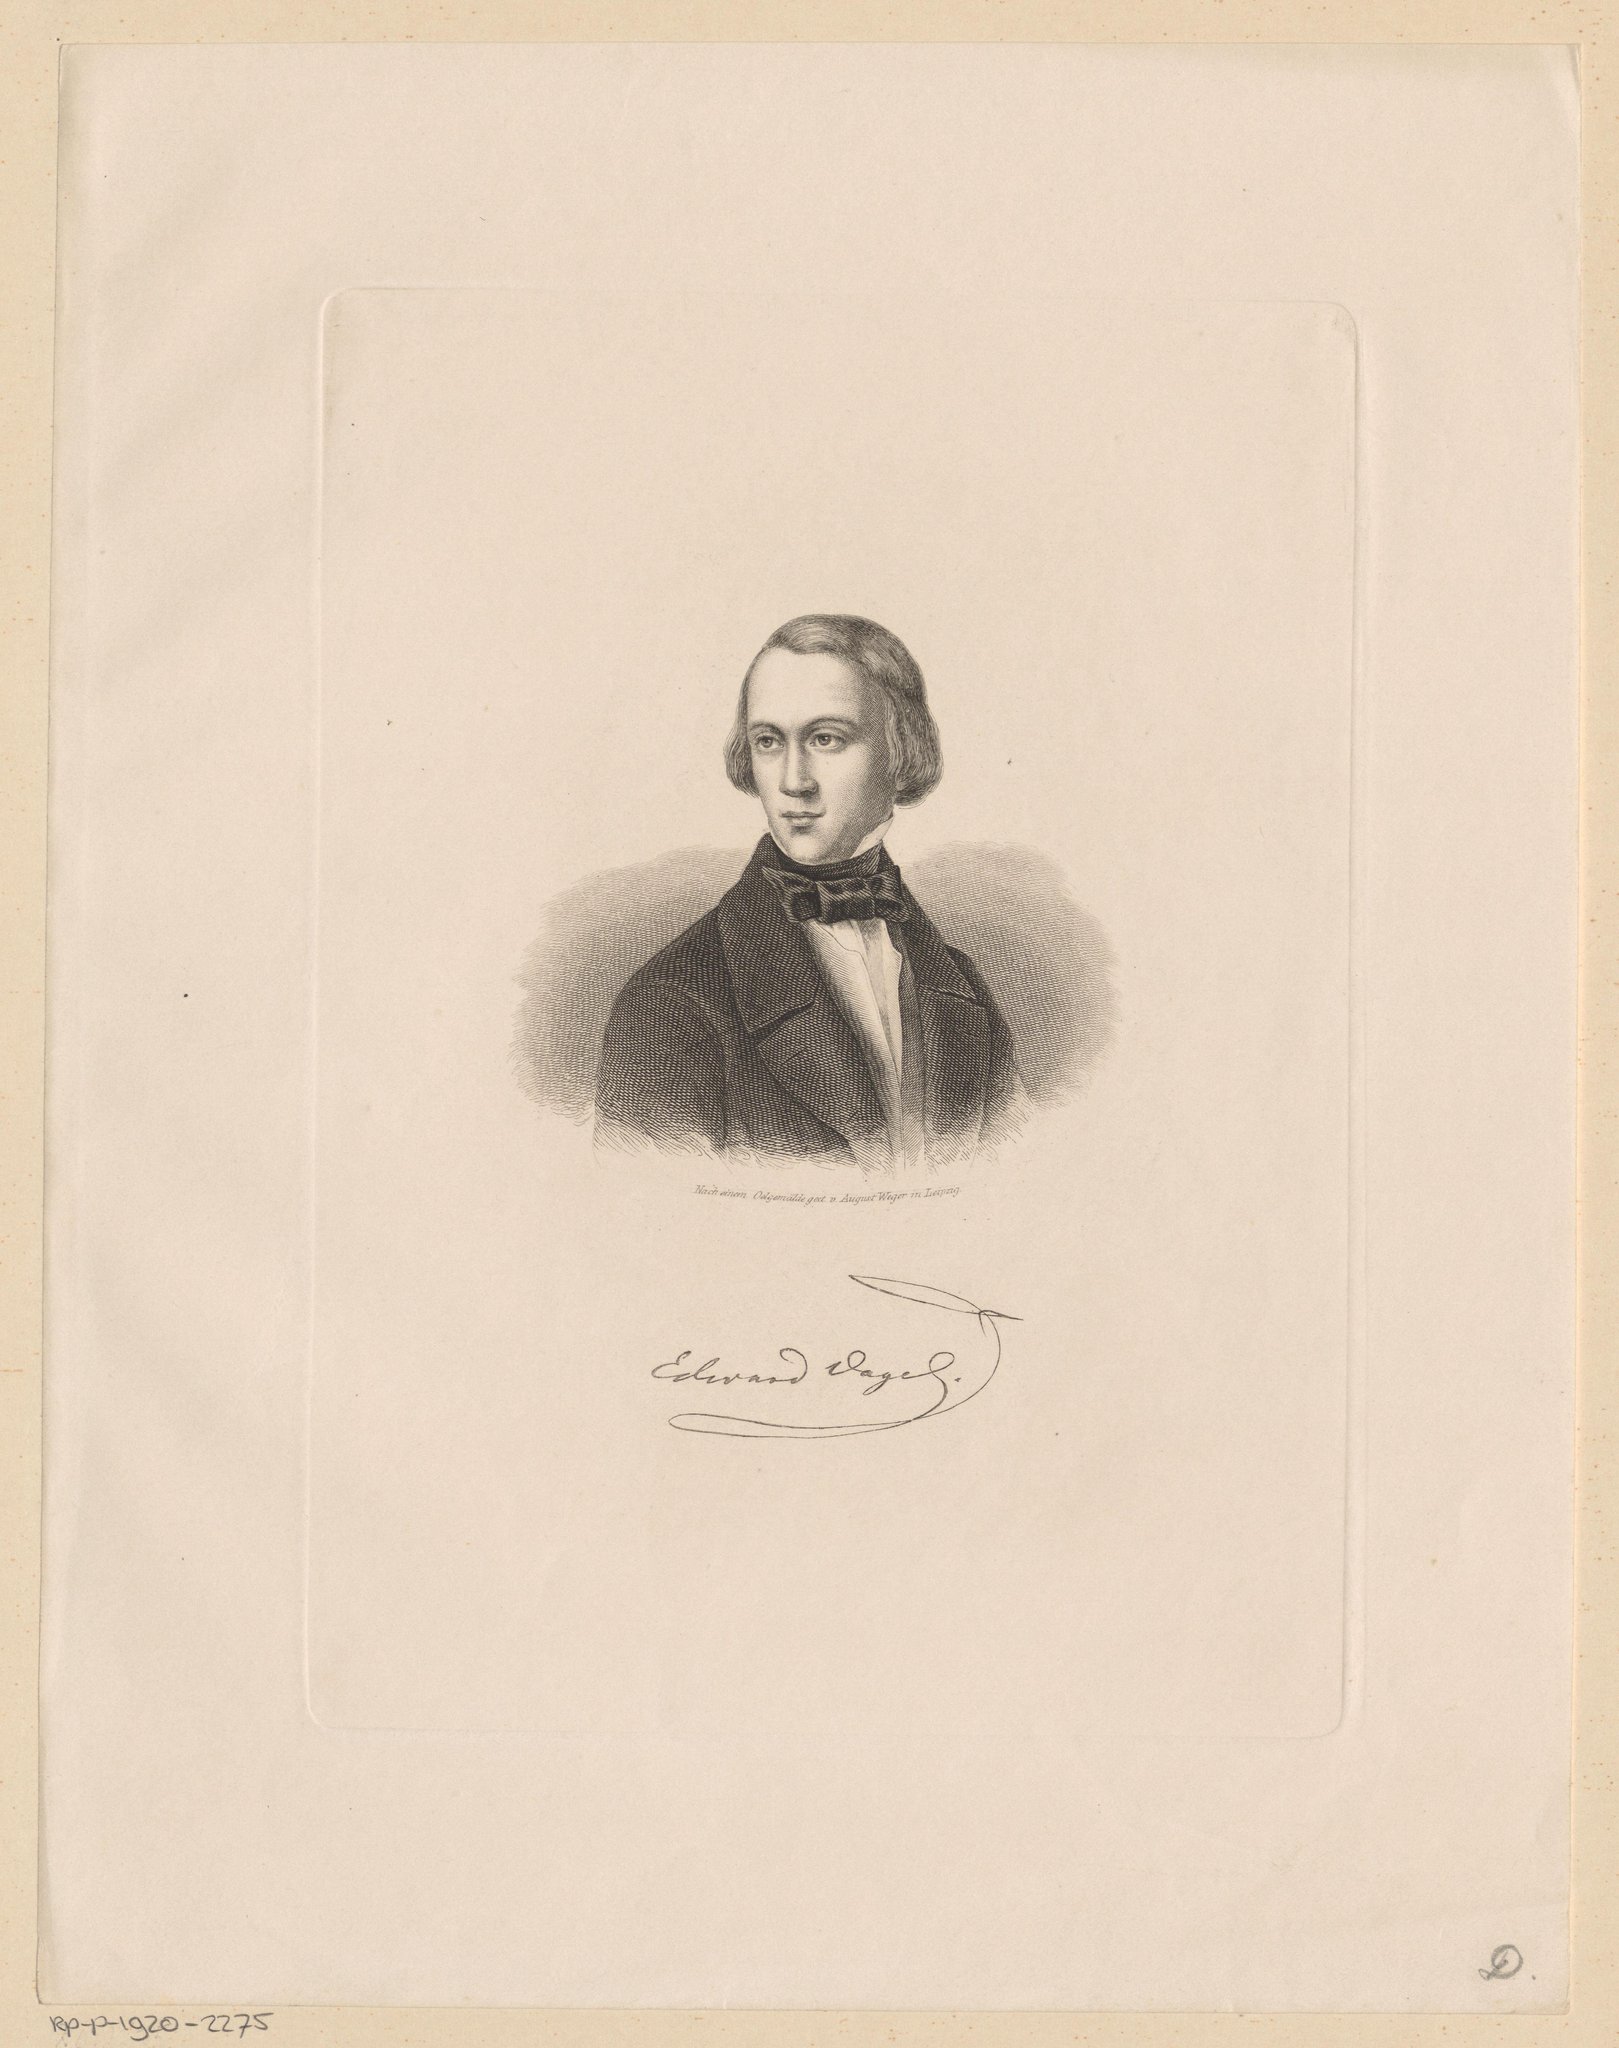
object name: print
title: Portret van Eduard Vogel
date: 1849-1892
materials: paper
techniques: engraving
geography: leipzig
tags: historical persons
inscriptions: collector's mark: Lugt 2228